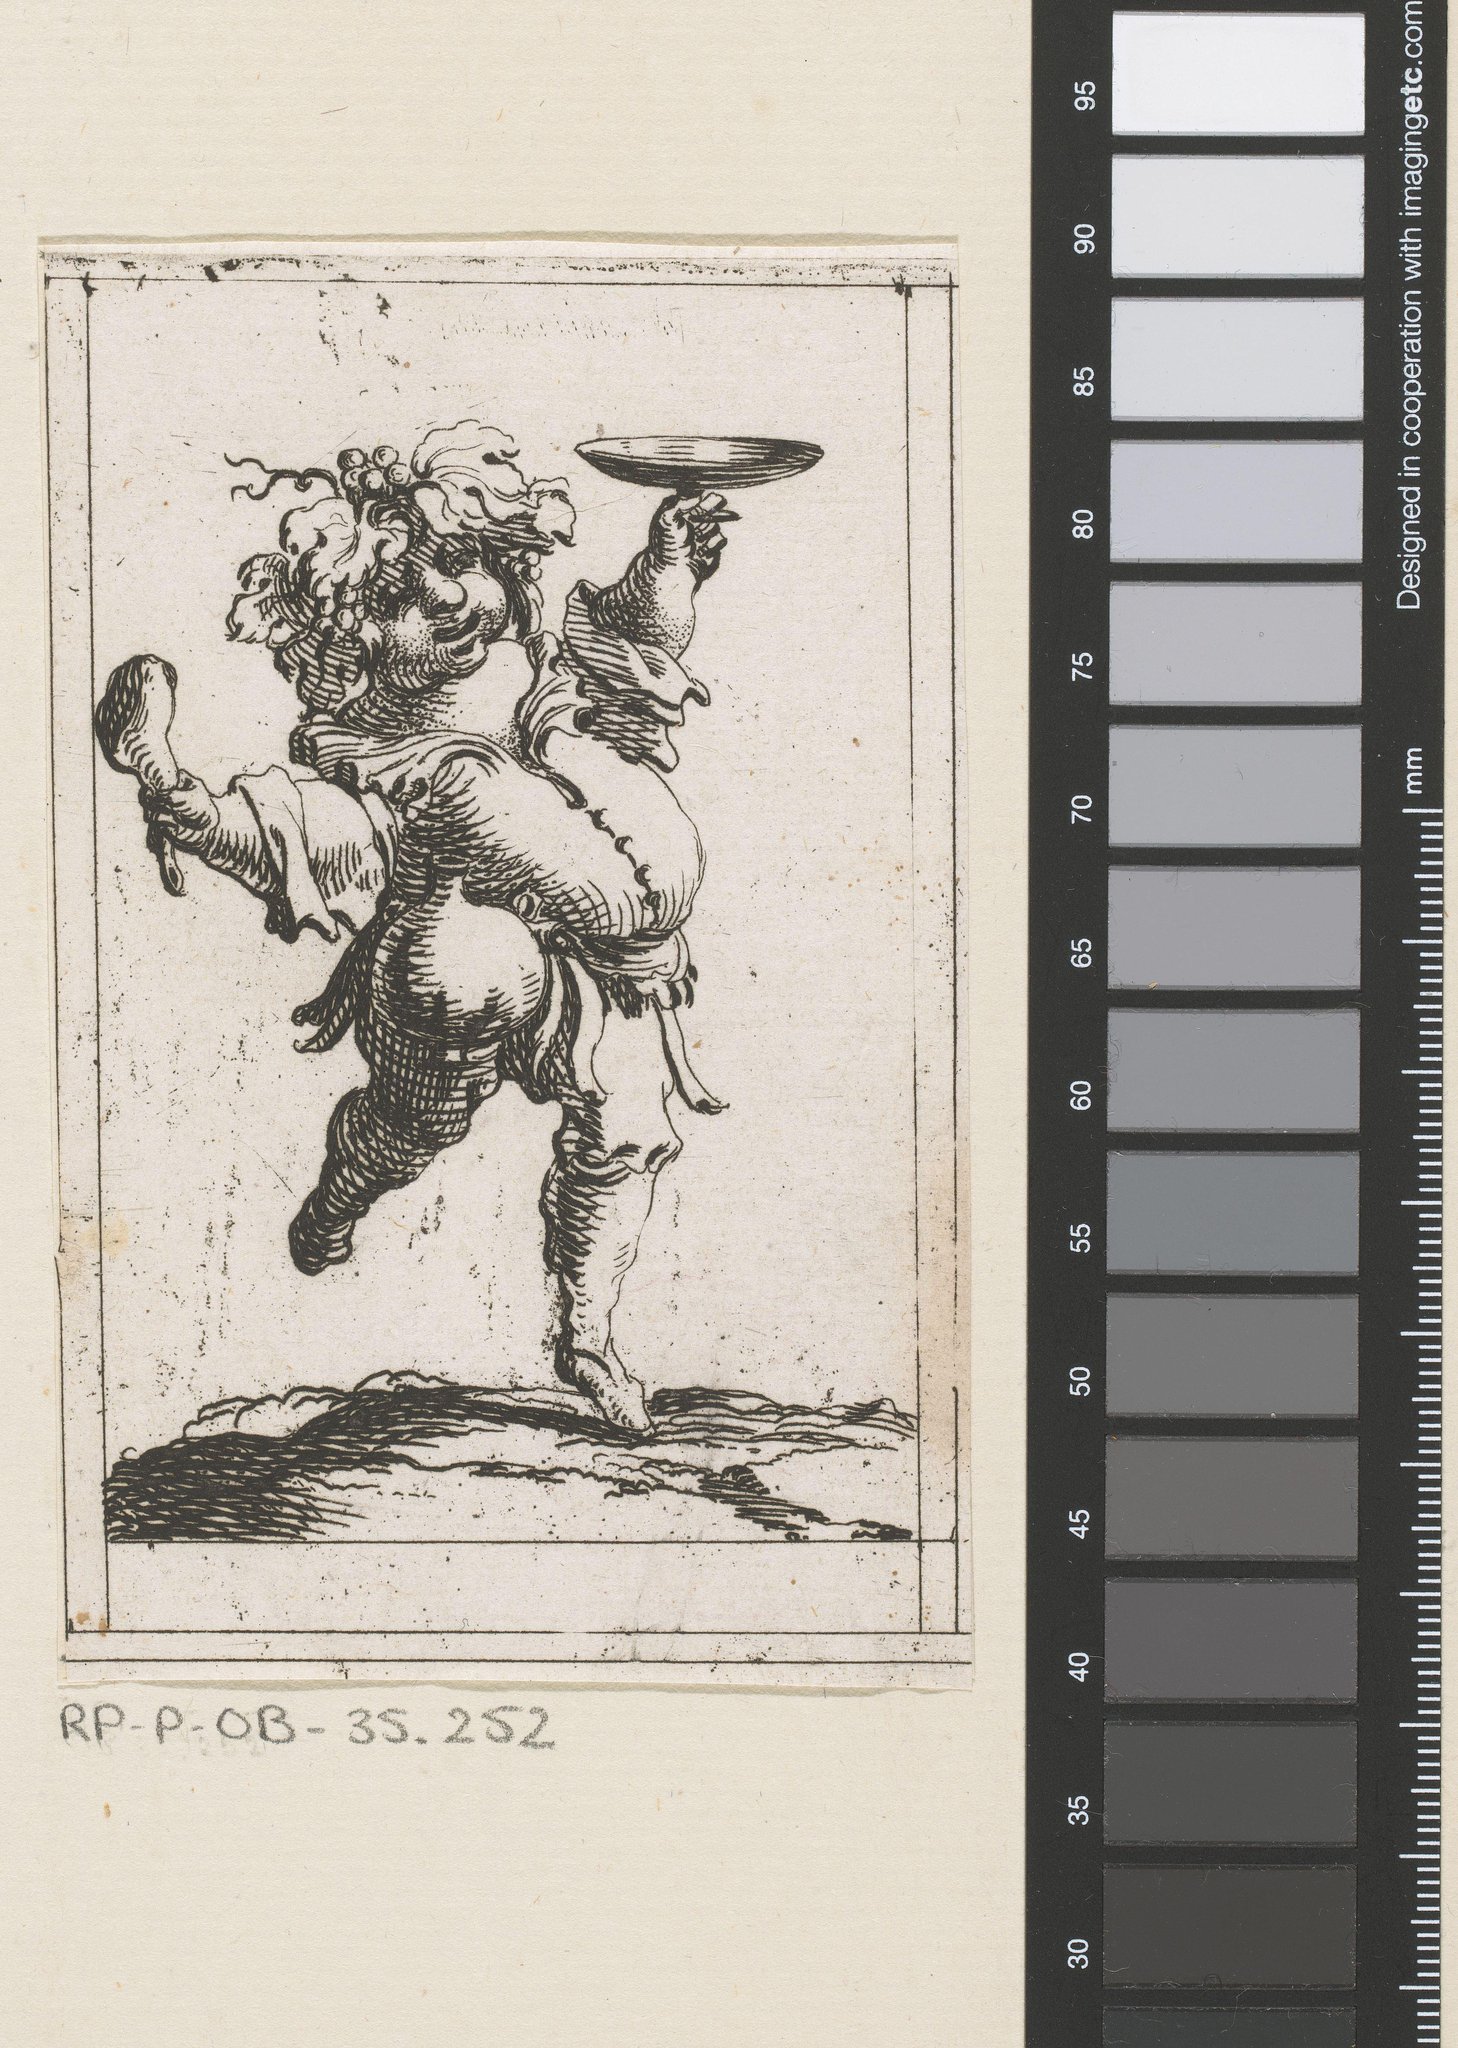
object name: print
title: September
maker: denis boutemie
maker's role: print maker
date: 1633-1643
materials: paper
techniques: etching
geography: paris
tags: september; 'settembre' (ripa)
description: Personificatie van de maand september. Een groteske Bacchusfiguur danst met een stuk ham en een bokaal in zijn handen.